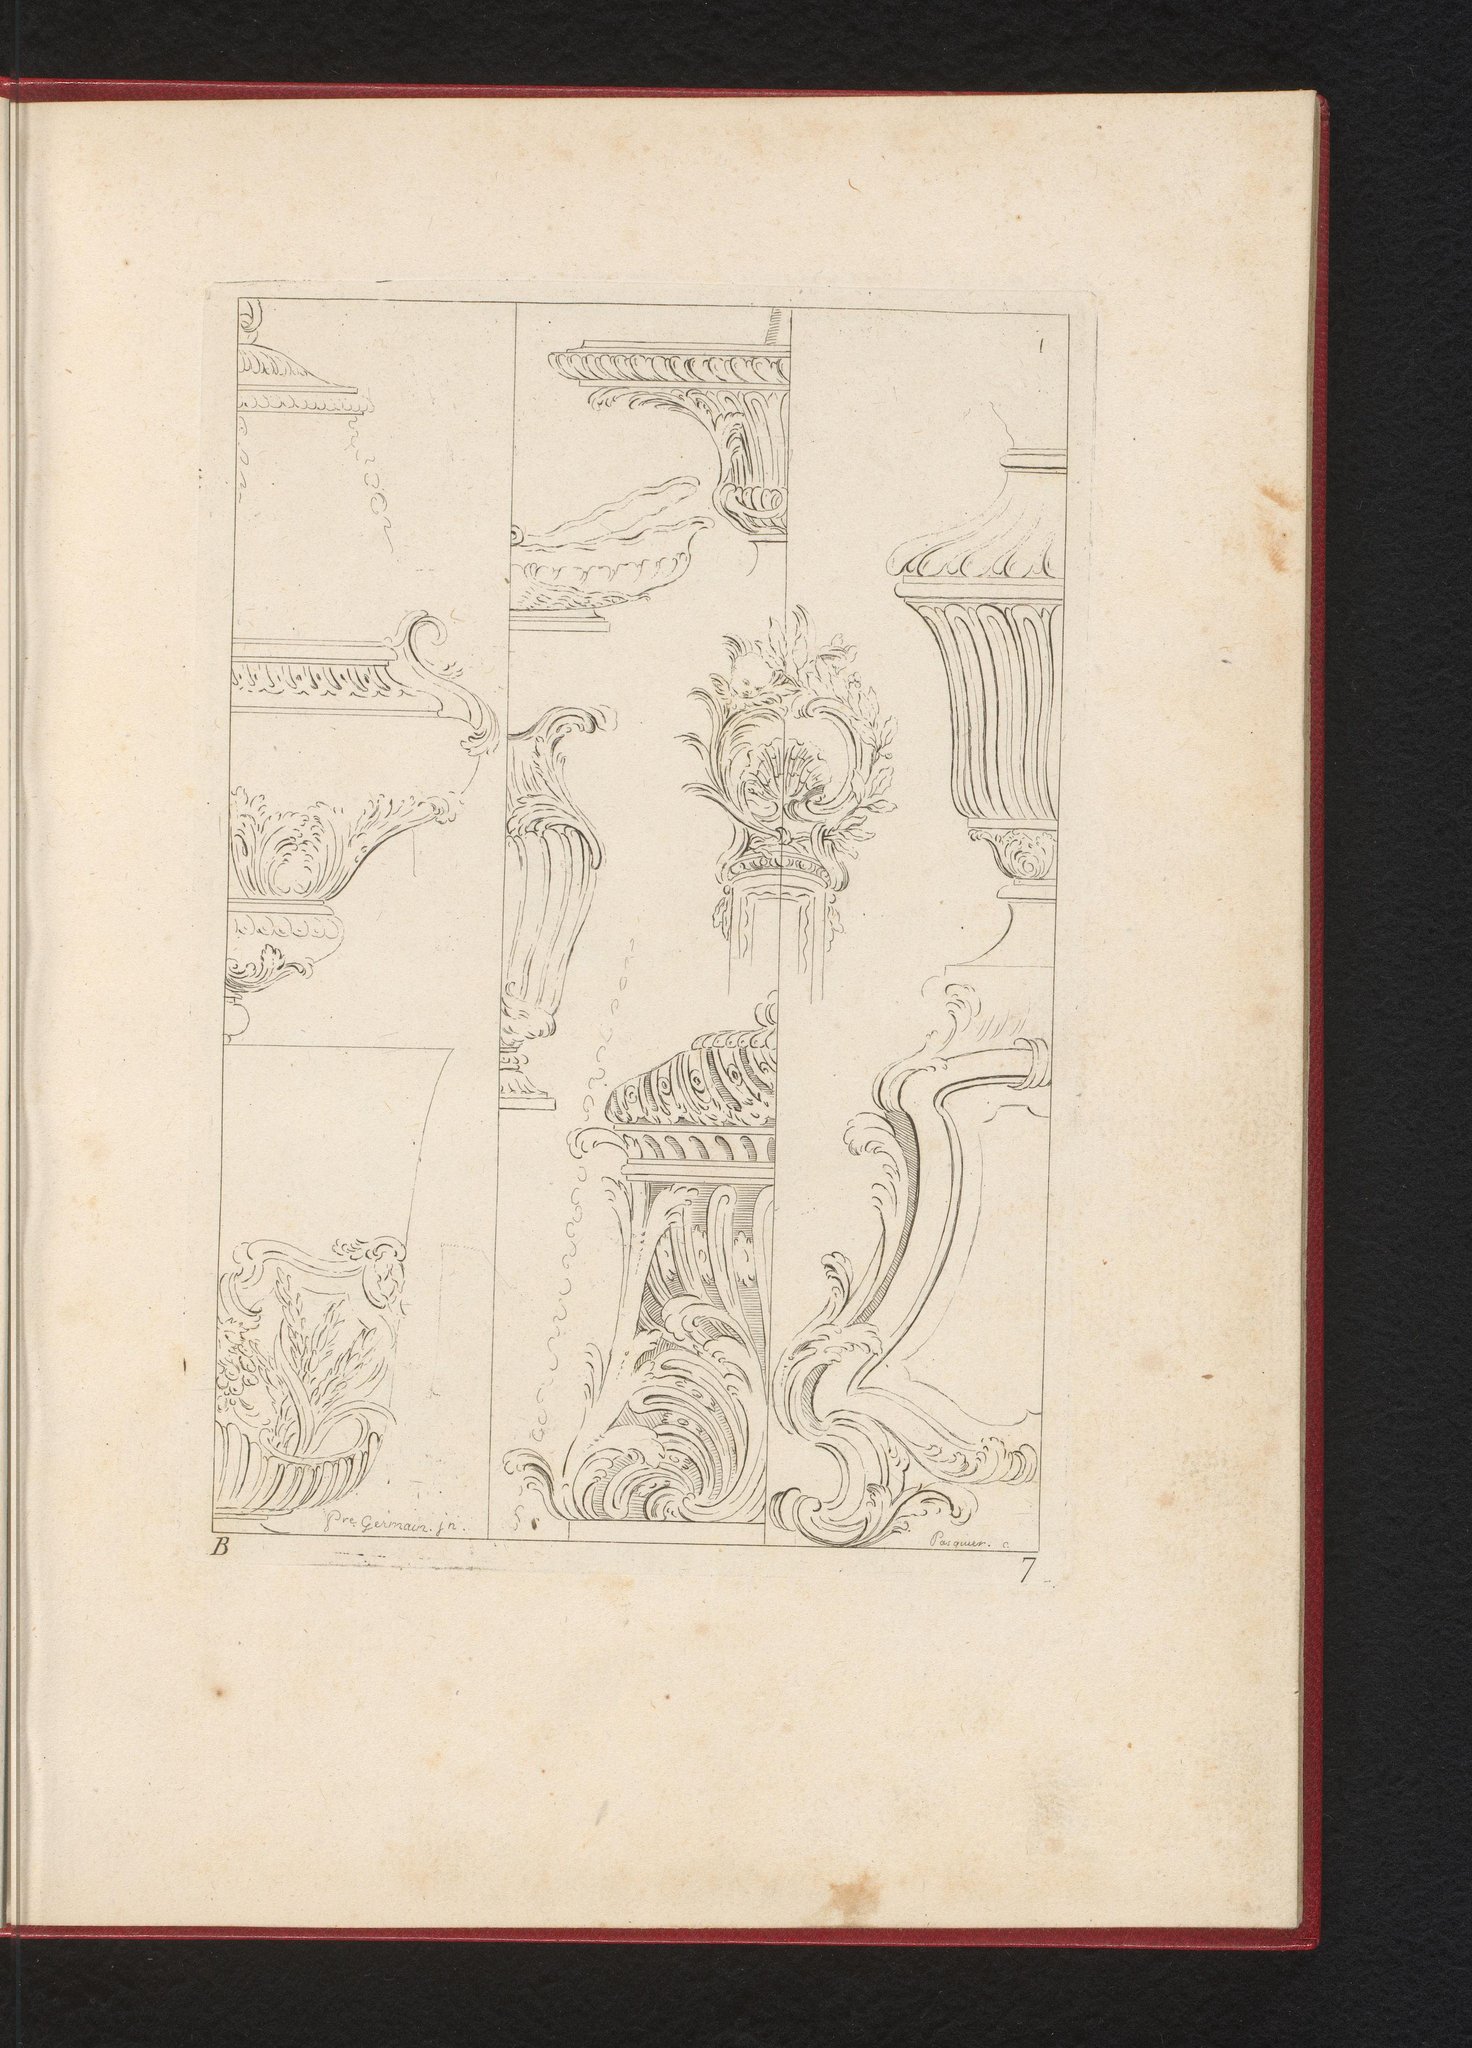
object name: album leaf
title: Zilverwerk en edelsmeedkunst, eerste deel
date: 1748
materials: paper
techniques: etching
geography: paris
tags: ornaments ~ art, interior of church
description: Een aantal van de objecten in deze reeks heeft een eigen ondertitel, die verwijst naar genummerde 'cahiers' (afleveringen) waarin de prenten werden uitgegeven. Het is onduidelijk welke objecten recies bij welke aflevering horen. Daarom is die ondertitel enkel verwerkt bij de prent waarop die voorkomt.